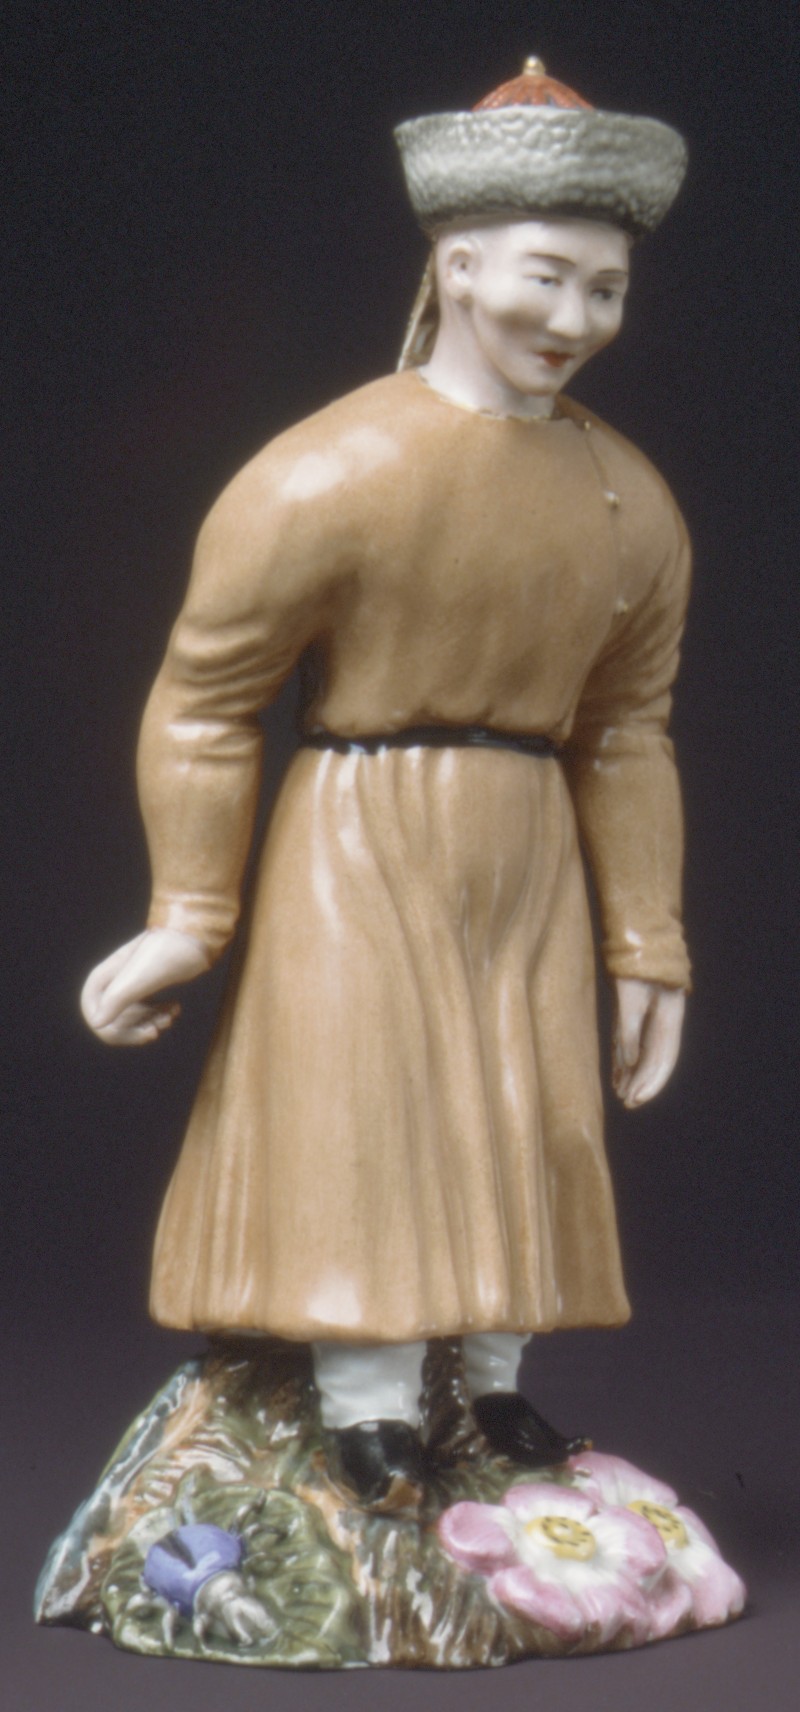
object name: figure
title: Oriental Man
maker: popov manufactory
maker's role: manufactory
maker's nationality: russian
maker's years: 1811-1875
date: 1840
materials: hard paste porcelain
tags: men,flowers